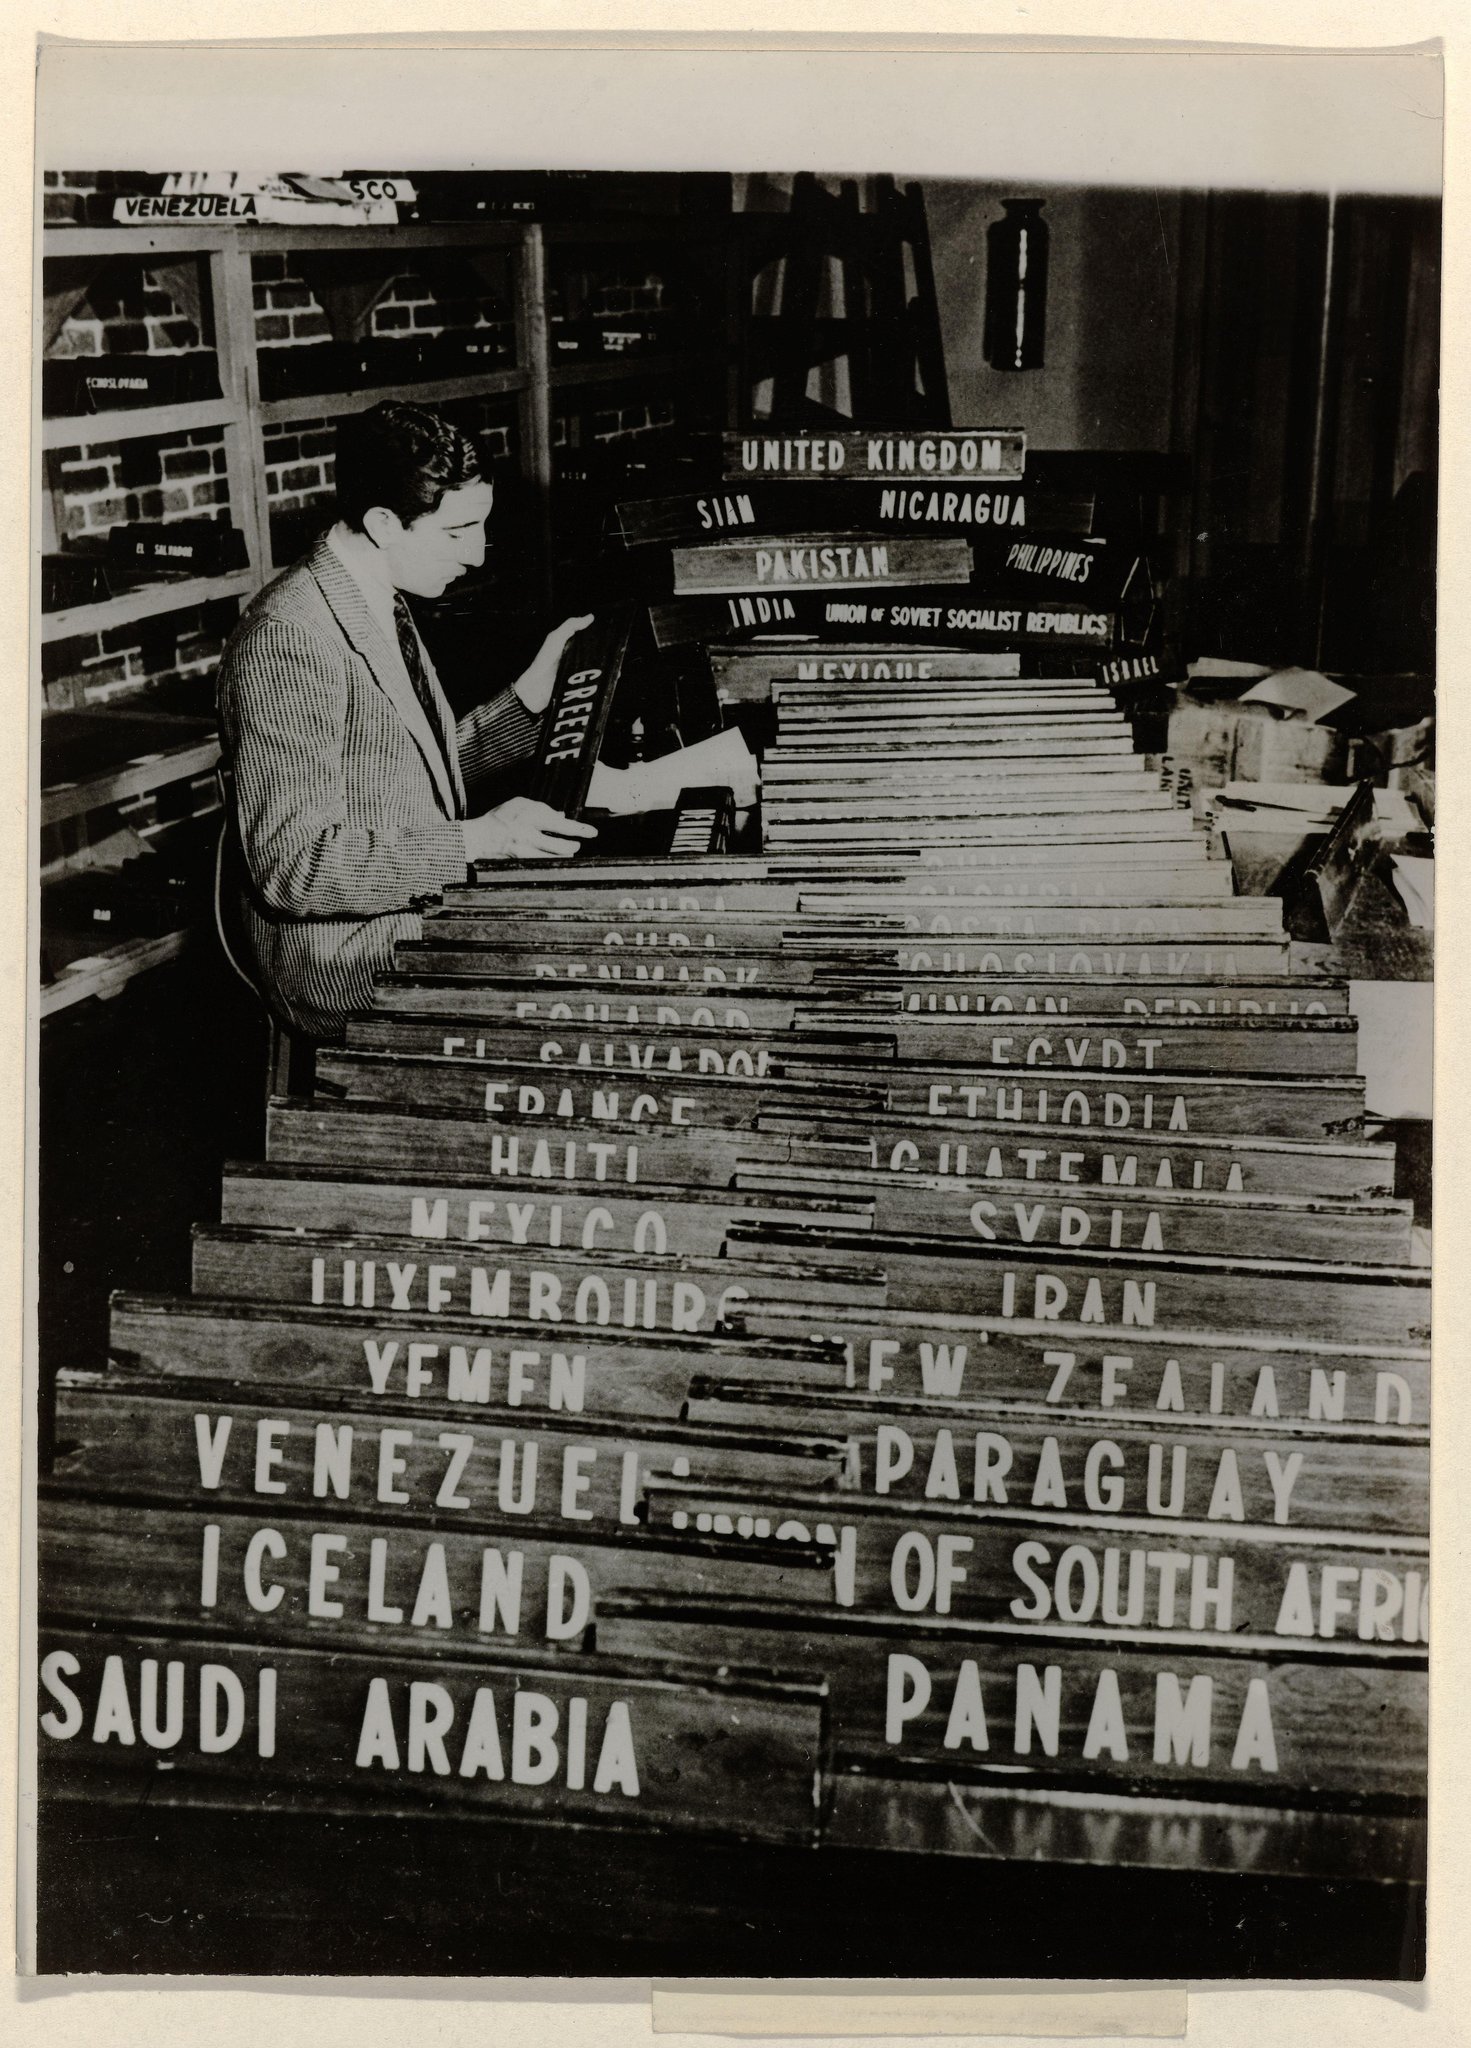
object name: photograph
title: Naambordjes voor diverse lidstaten van de Verenigde Naties, opgesteld op tafel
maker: Anonymous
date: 1949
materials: paper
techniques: gelatin silver print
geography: london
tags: meeting, assembly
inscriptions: inscription: ‘Scene in the Secretariat's Department at/ Lake Success, New York, as a staff worker prepares the/ name plates for the second part of the United Nations/ General Assembly which is due to start there on April/ 5th. The first part of the General Assembly was held/ in the Palais de Chaillot, Paris../ x2 1/JSS KEYSTONE 544206.’